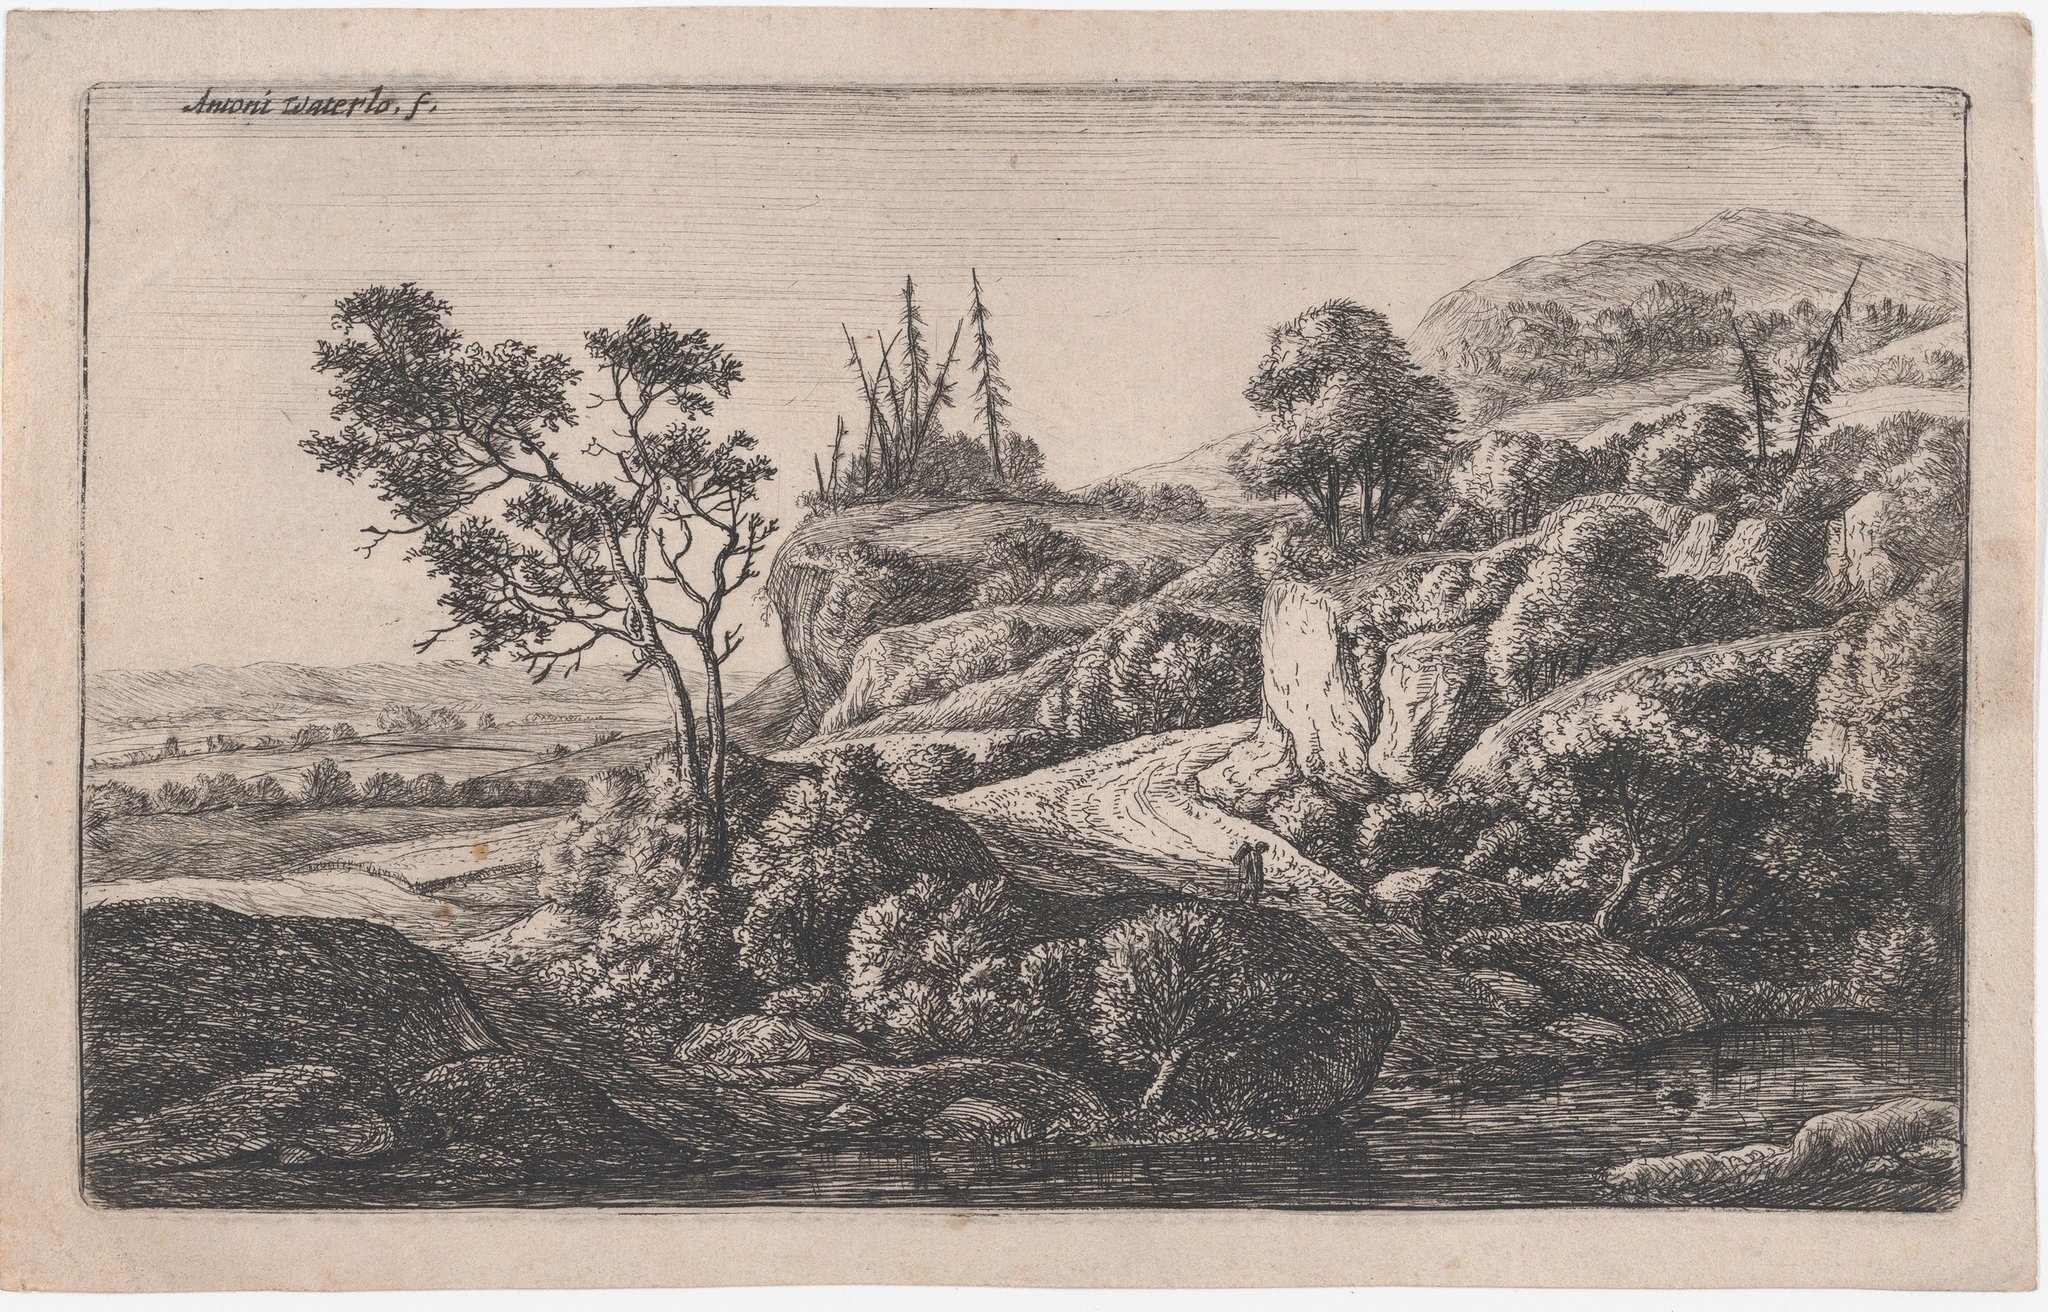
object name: print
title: Paths Leading To a Stream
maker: anthonie waterloo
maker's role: artist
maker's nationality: dutch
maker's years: 1609-1690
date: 1601-1700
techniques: etching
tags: landscapes